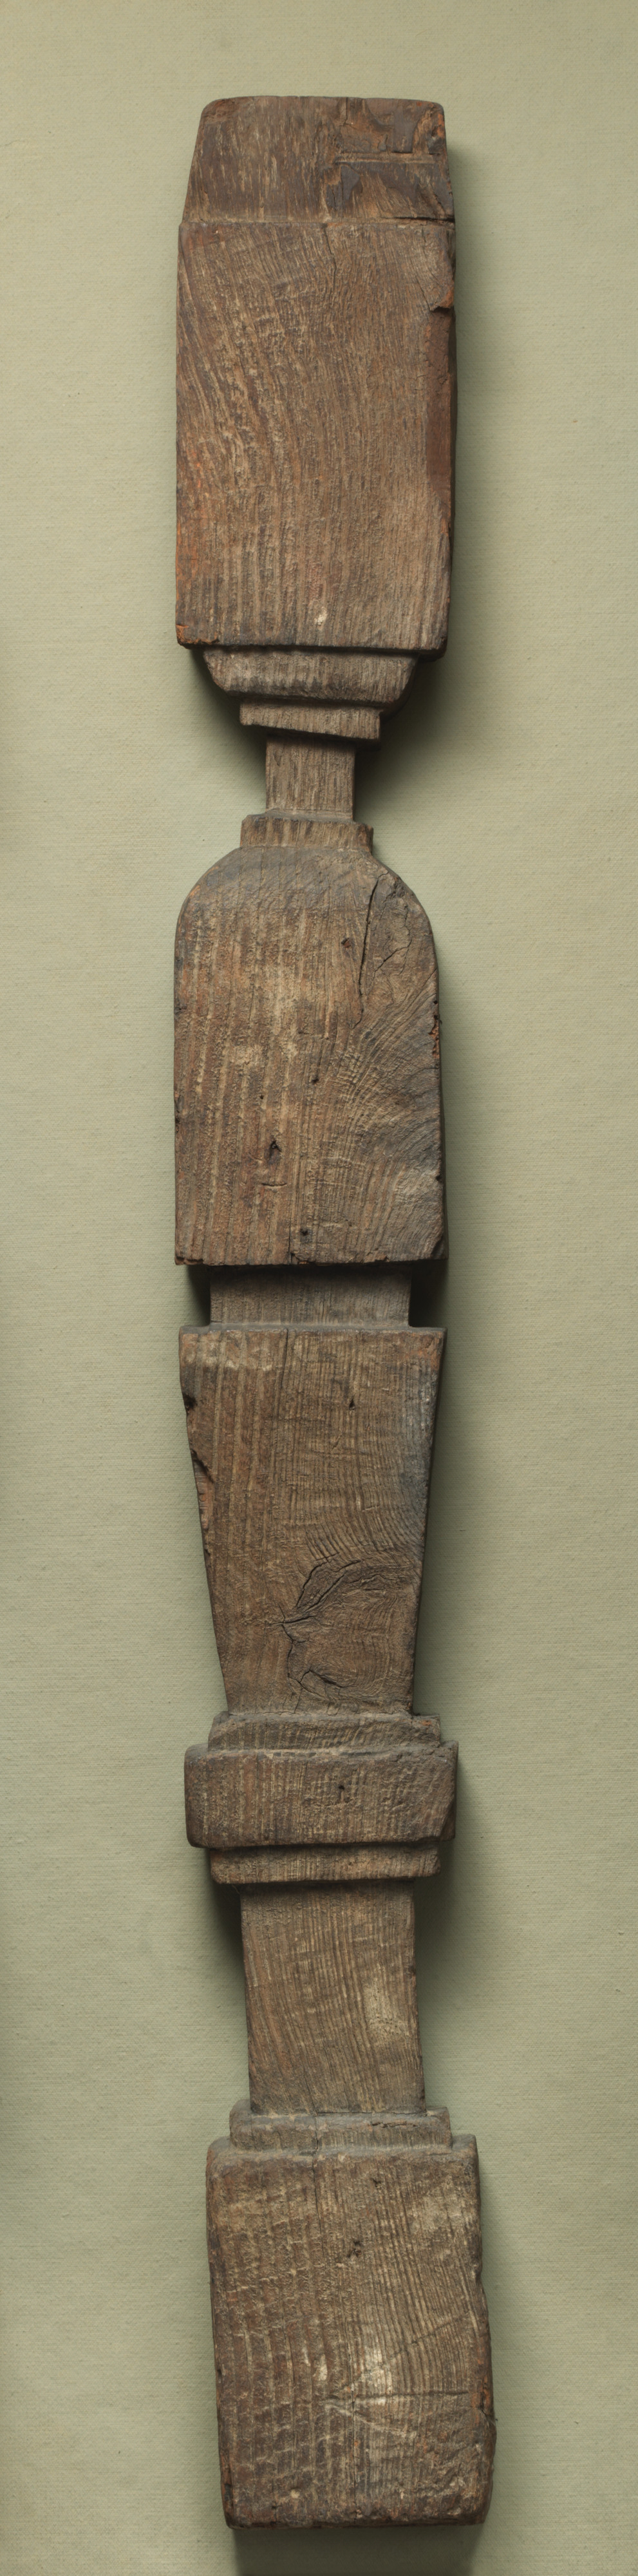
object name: baluster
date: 1501-1600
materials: wood